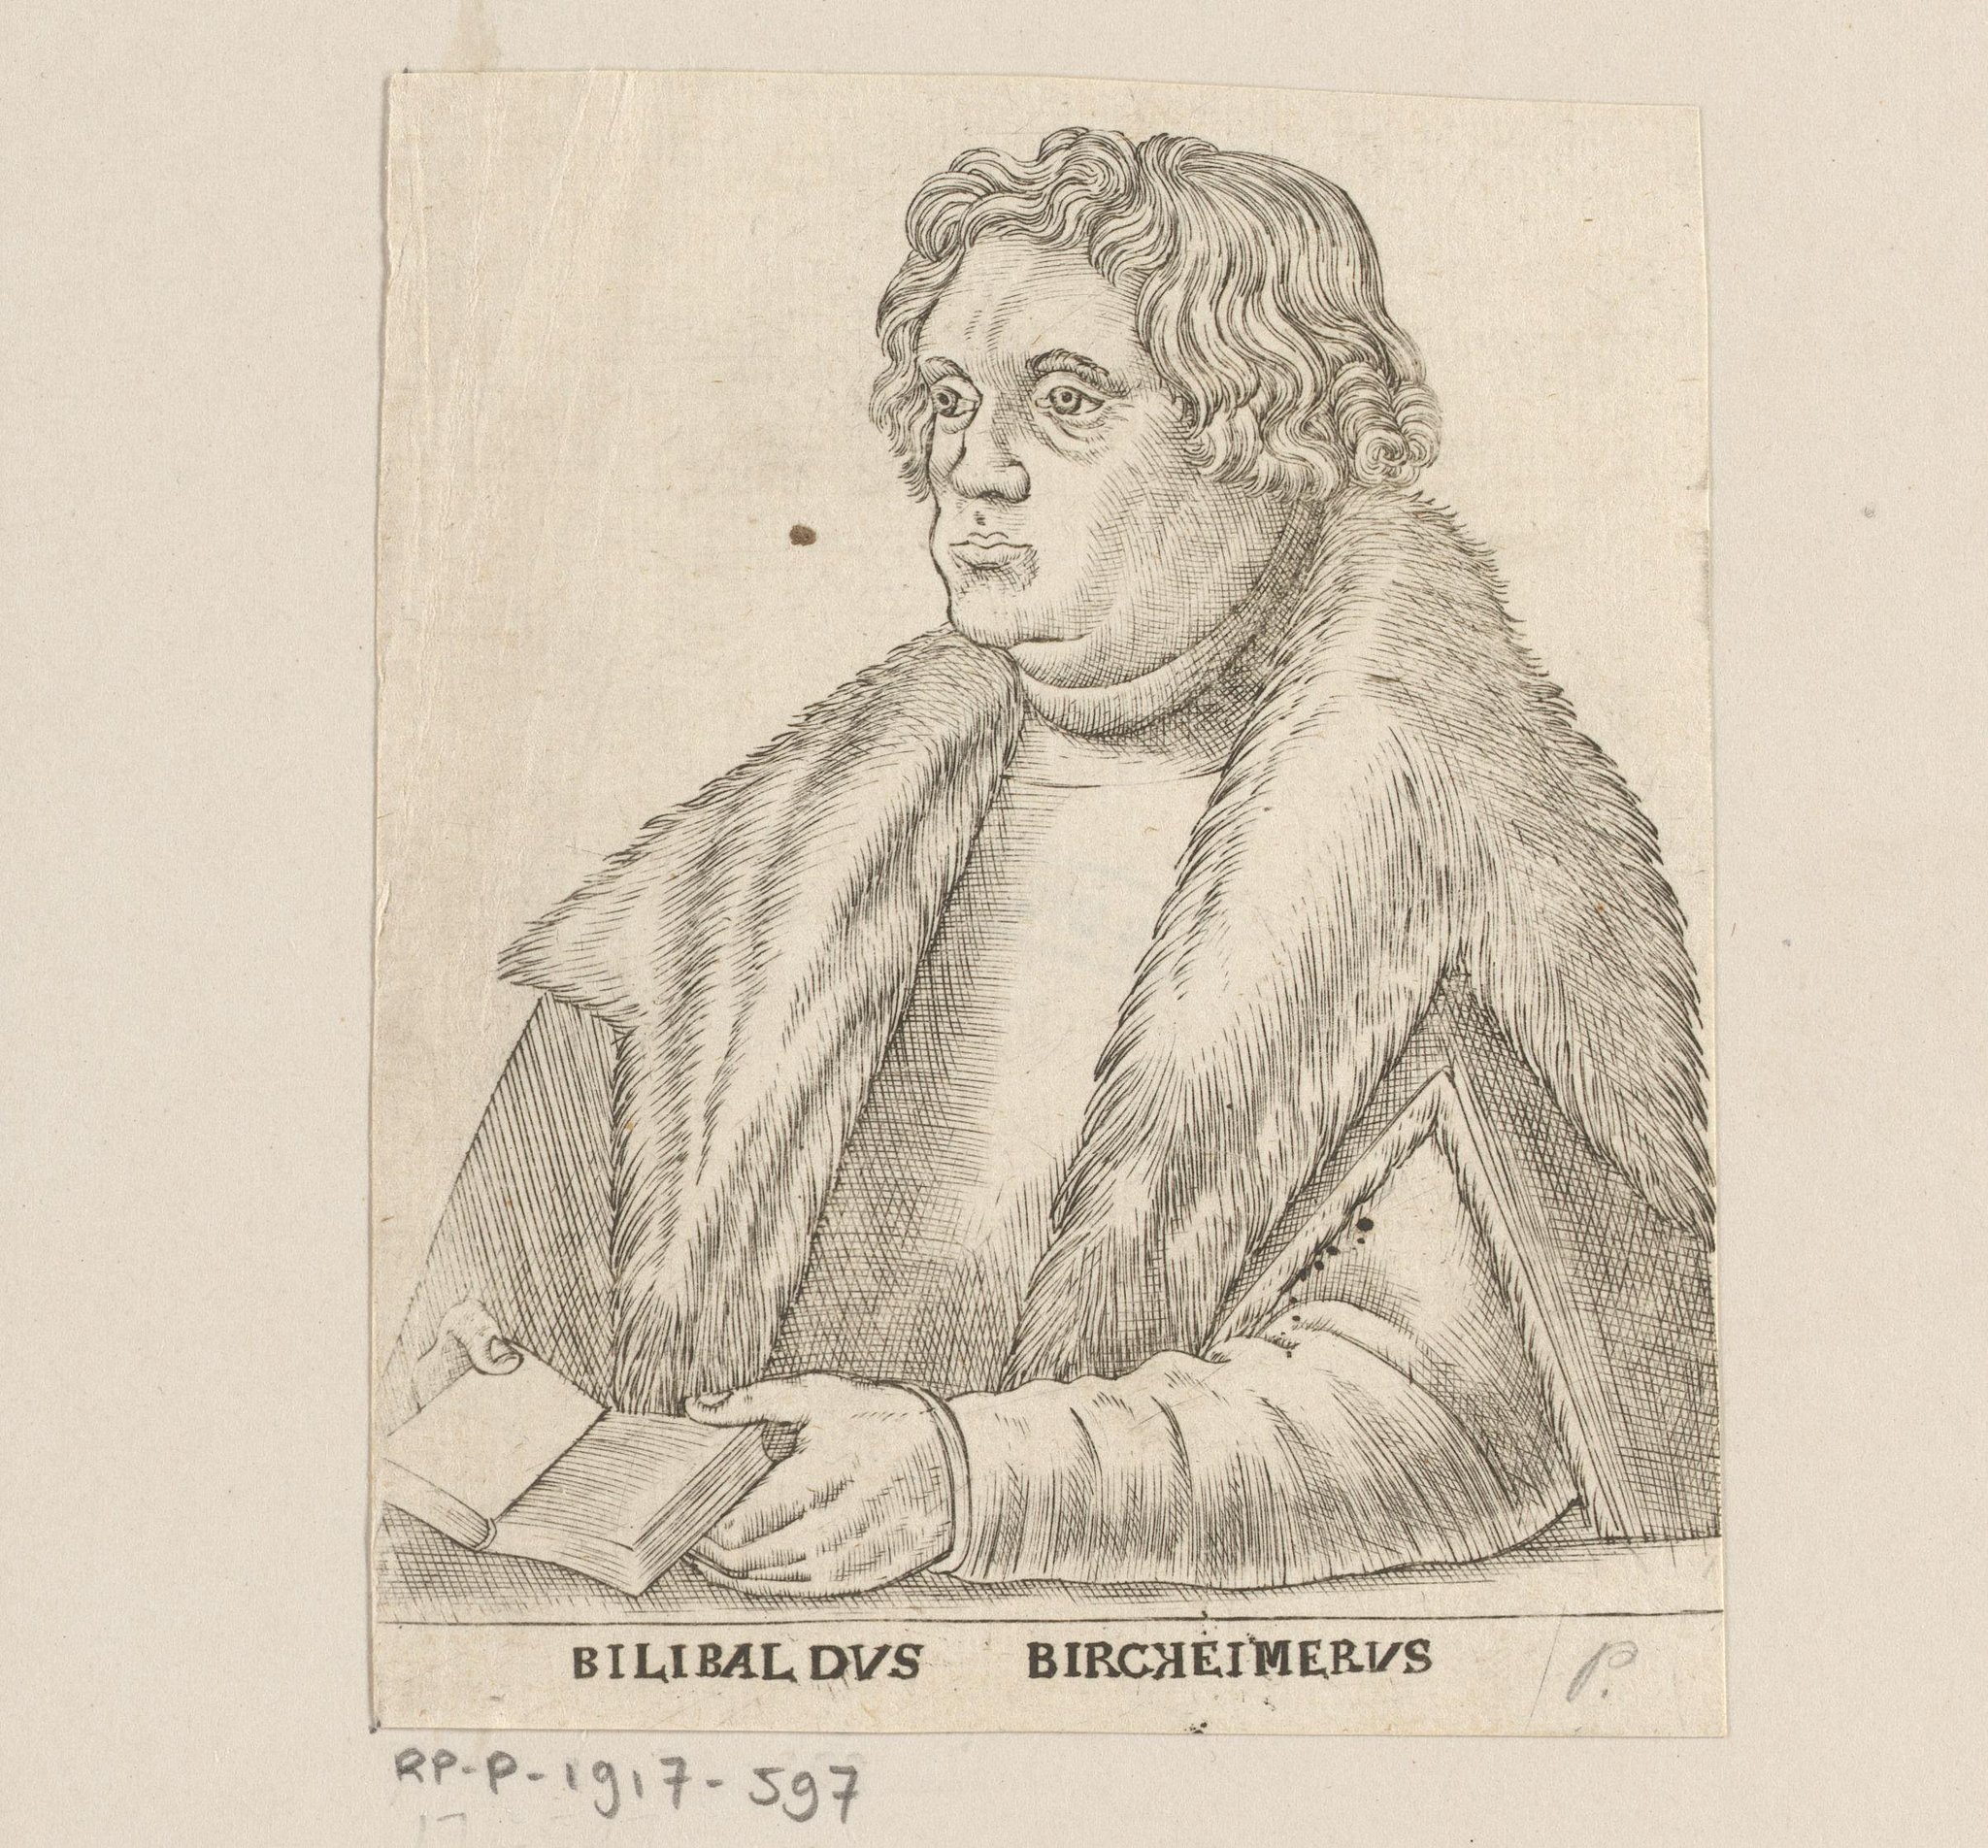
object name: print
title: Bilibaldus Birckeimerus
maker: Anonymous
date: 1650-1699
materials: paper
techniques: engraving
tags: eichstätt, willibald pirckheimer, historical persons, portrait of a writer, book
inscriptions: collector's mark: Lugt 2228